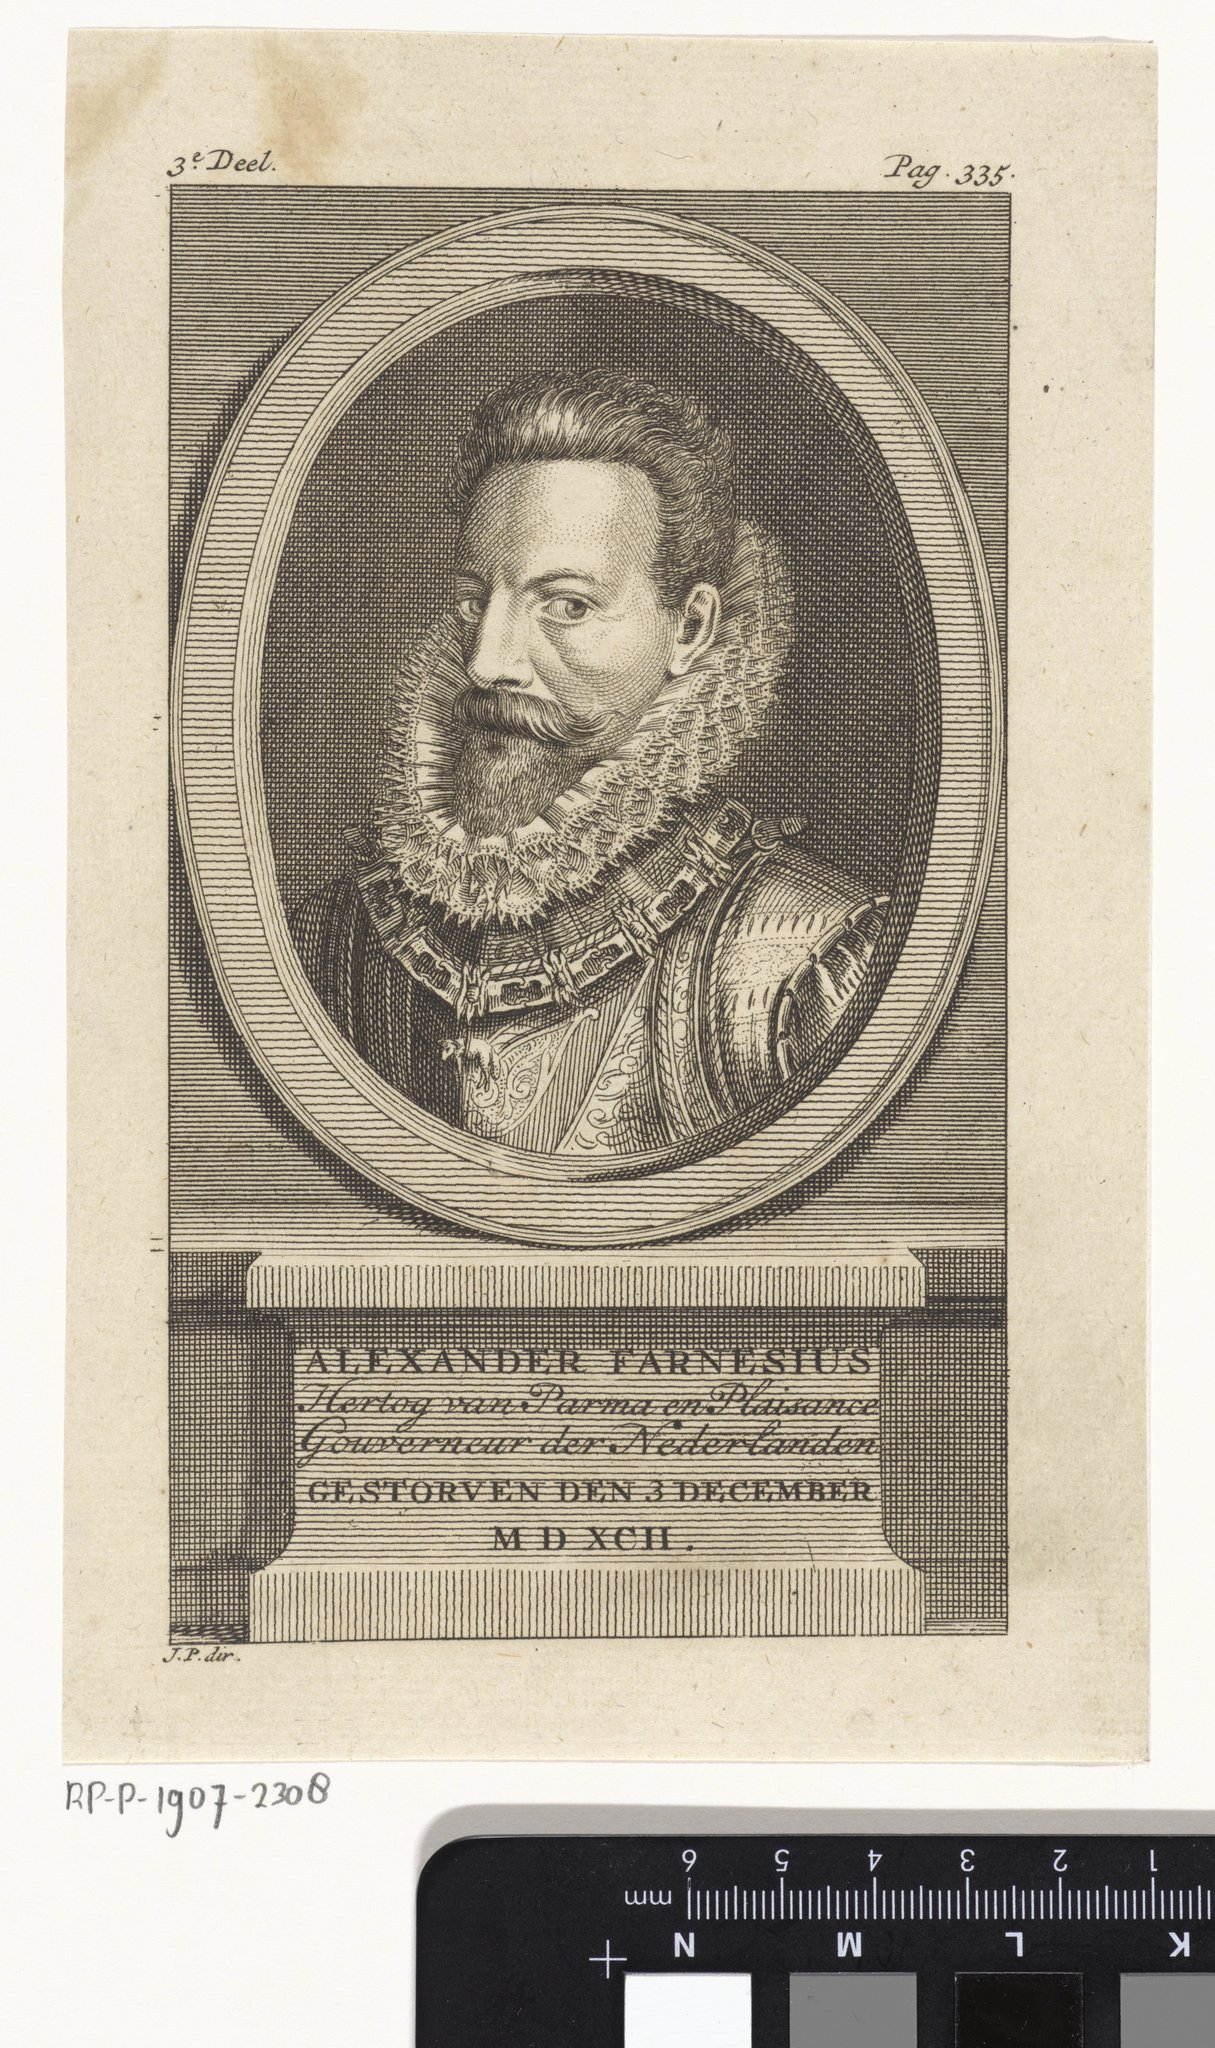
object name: book illustration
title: Portret van Alessandro Farnese, hertog van Parma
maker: jan punt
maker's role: draughtsman, print maker, publisher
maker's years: 1711-1779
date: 1750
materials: paper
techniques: engraving, etching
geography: northern netherlands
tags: rome, alessandro farnese (landvoogd van de nederlanden en hertog van parma en piacenza), armour, knighthood order of the golden fleece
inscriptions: collector's mark: Lugt 2228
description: Illustratie uit: Meteren, Emanuel van. Historie van de oorlogen en geschiedenissen der Nederlanderen, en der zelver naburen: beginnende met den jare 1315, en eindigende met den jare 1611, deel III, p. 335. Gorinchem/Breda: Nicolaas Goetzee/Willem Goetzee, 1750.